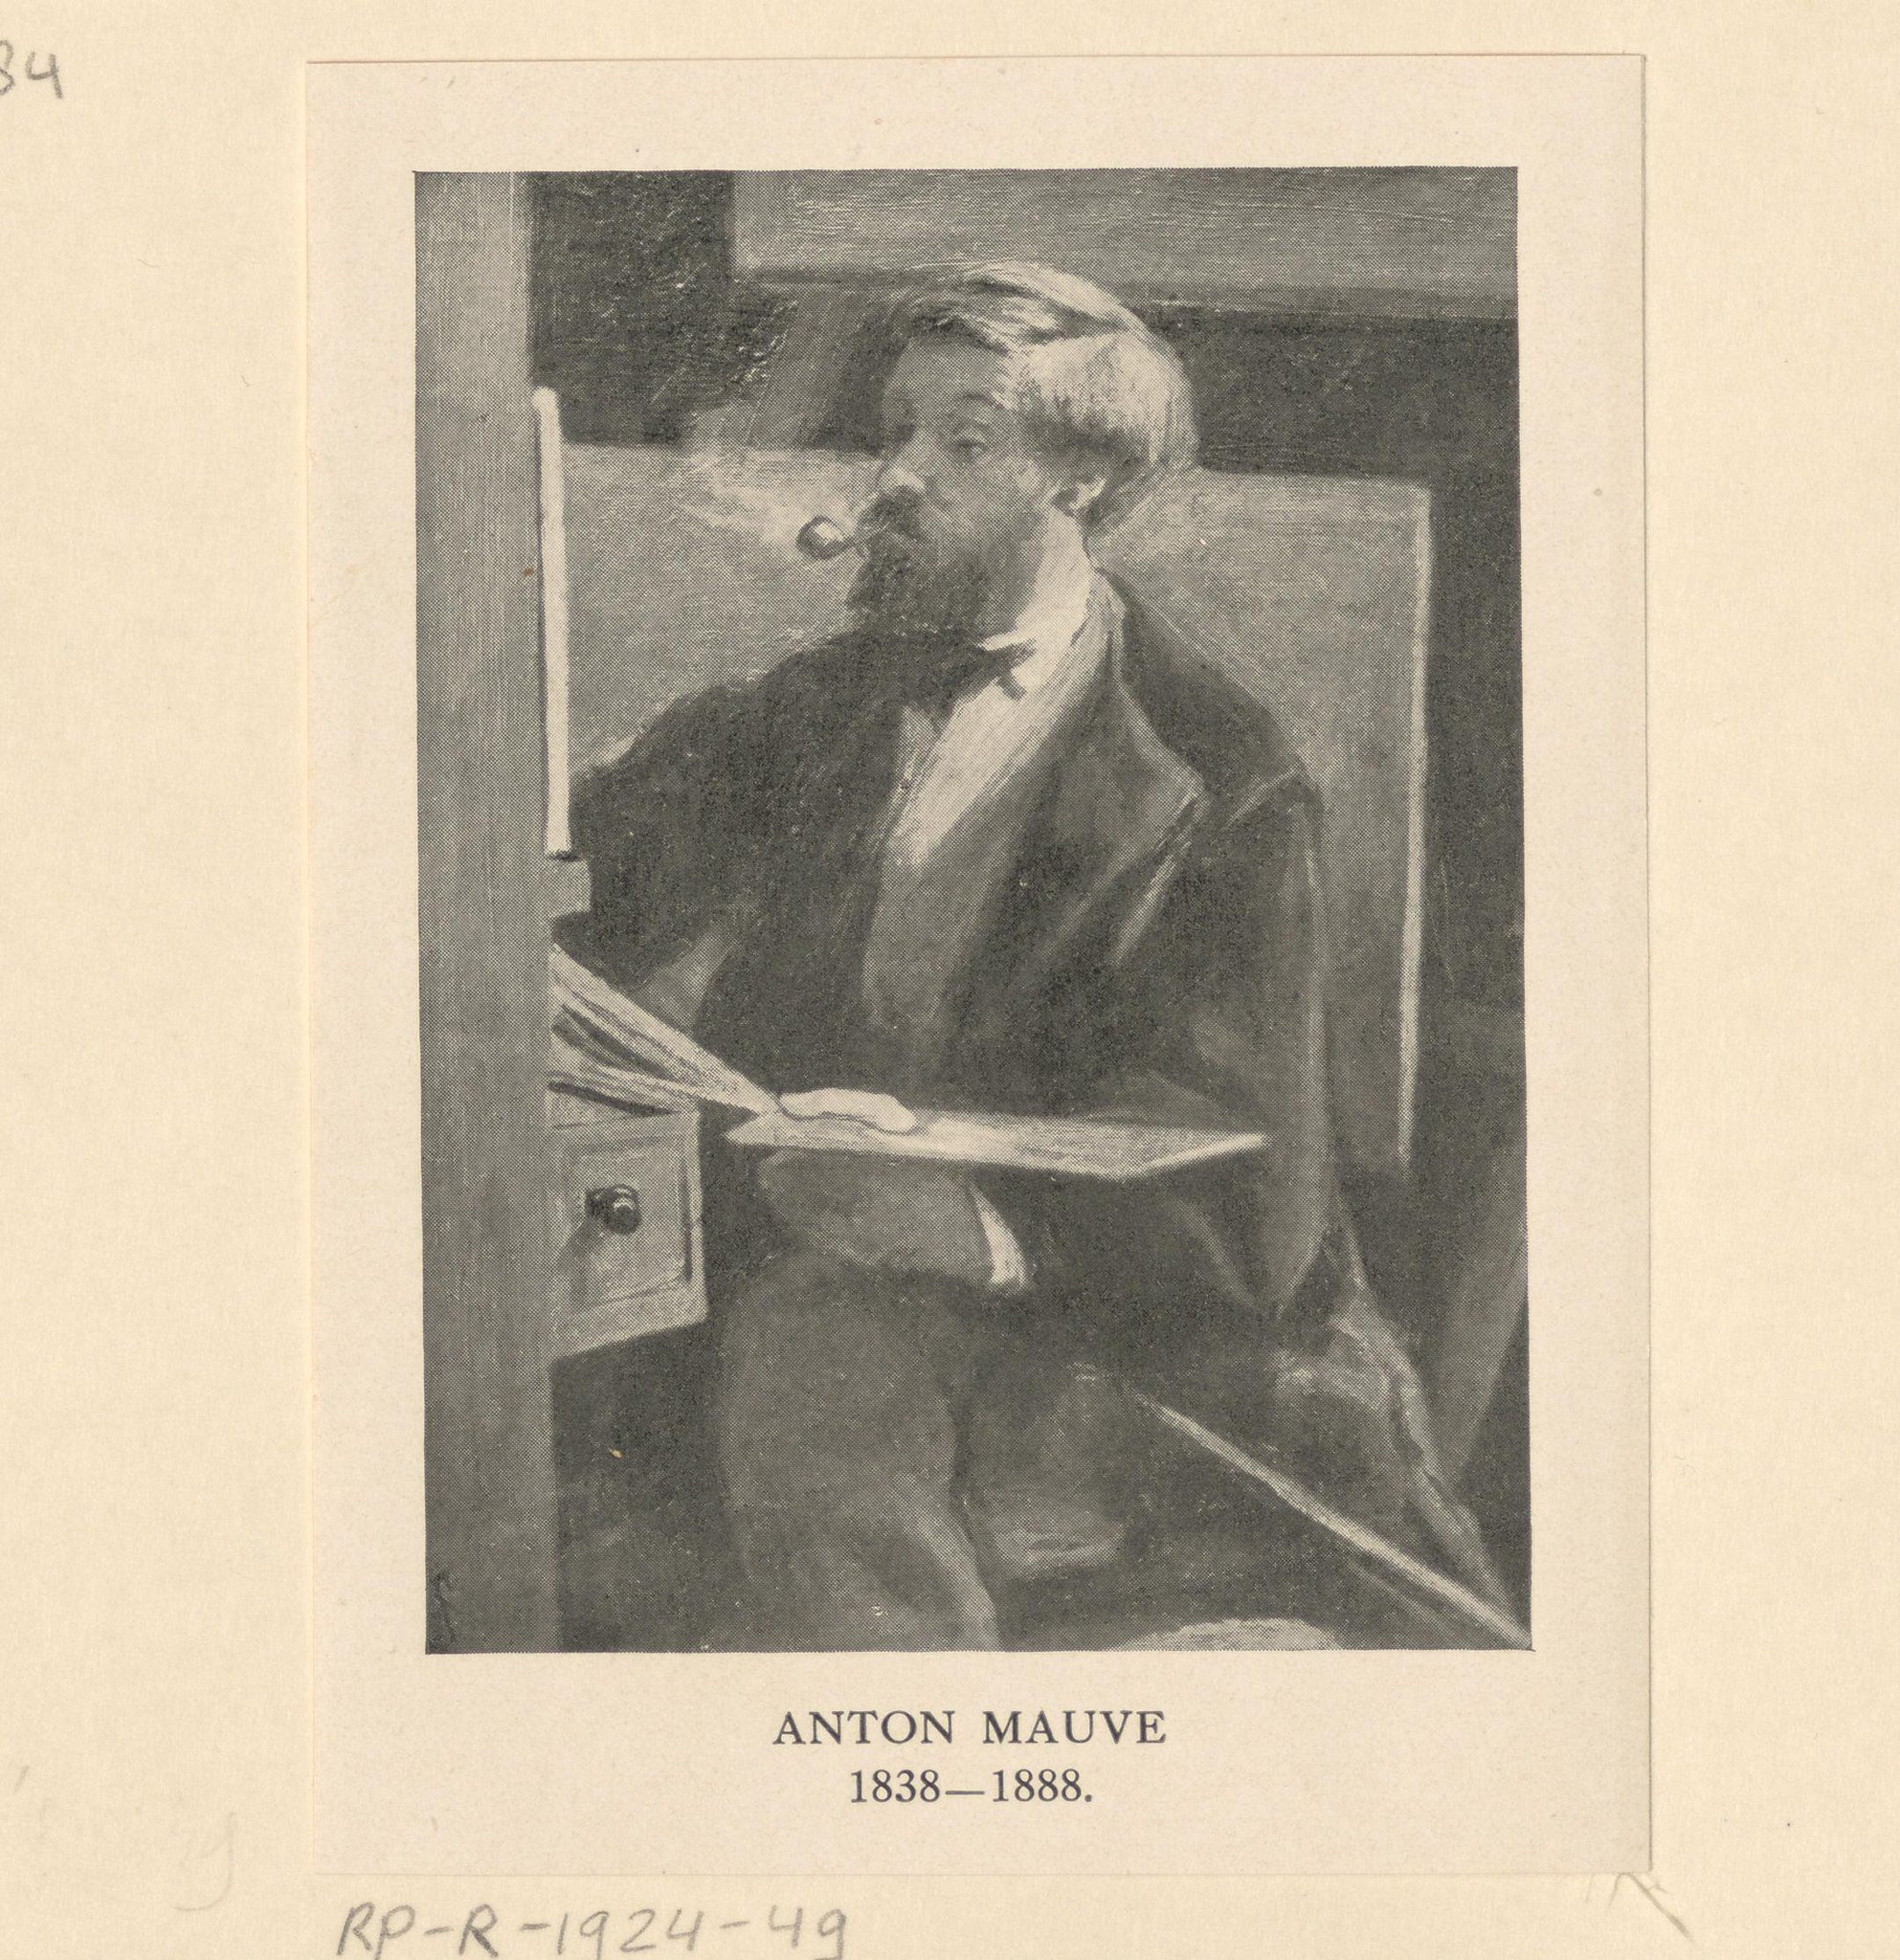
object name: photomechanical print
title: Portret van Anton Mauve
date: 1912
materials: paper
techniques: autotype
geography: netherlands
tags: arnhem, painter, draughtsman, anton mauve, historical persons, portrait, self-portrait of painter, palette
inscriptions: collector's mark: Lugt 2233, inscription: ‘uit cat. A. Preyer 1912’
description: Prent waarschijnlijk uit: Tentoonstelling van kunstwerken van J. Bosboom, J. Israëls, J. Maris, W. Maris, A. Mauve en enkele tijdgenooten uit de verzameling van A. Preyer. Amsterdam: s.n., 1912.